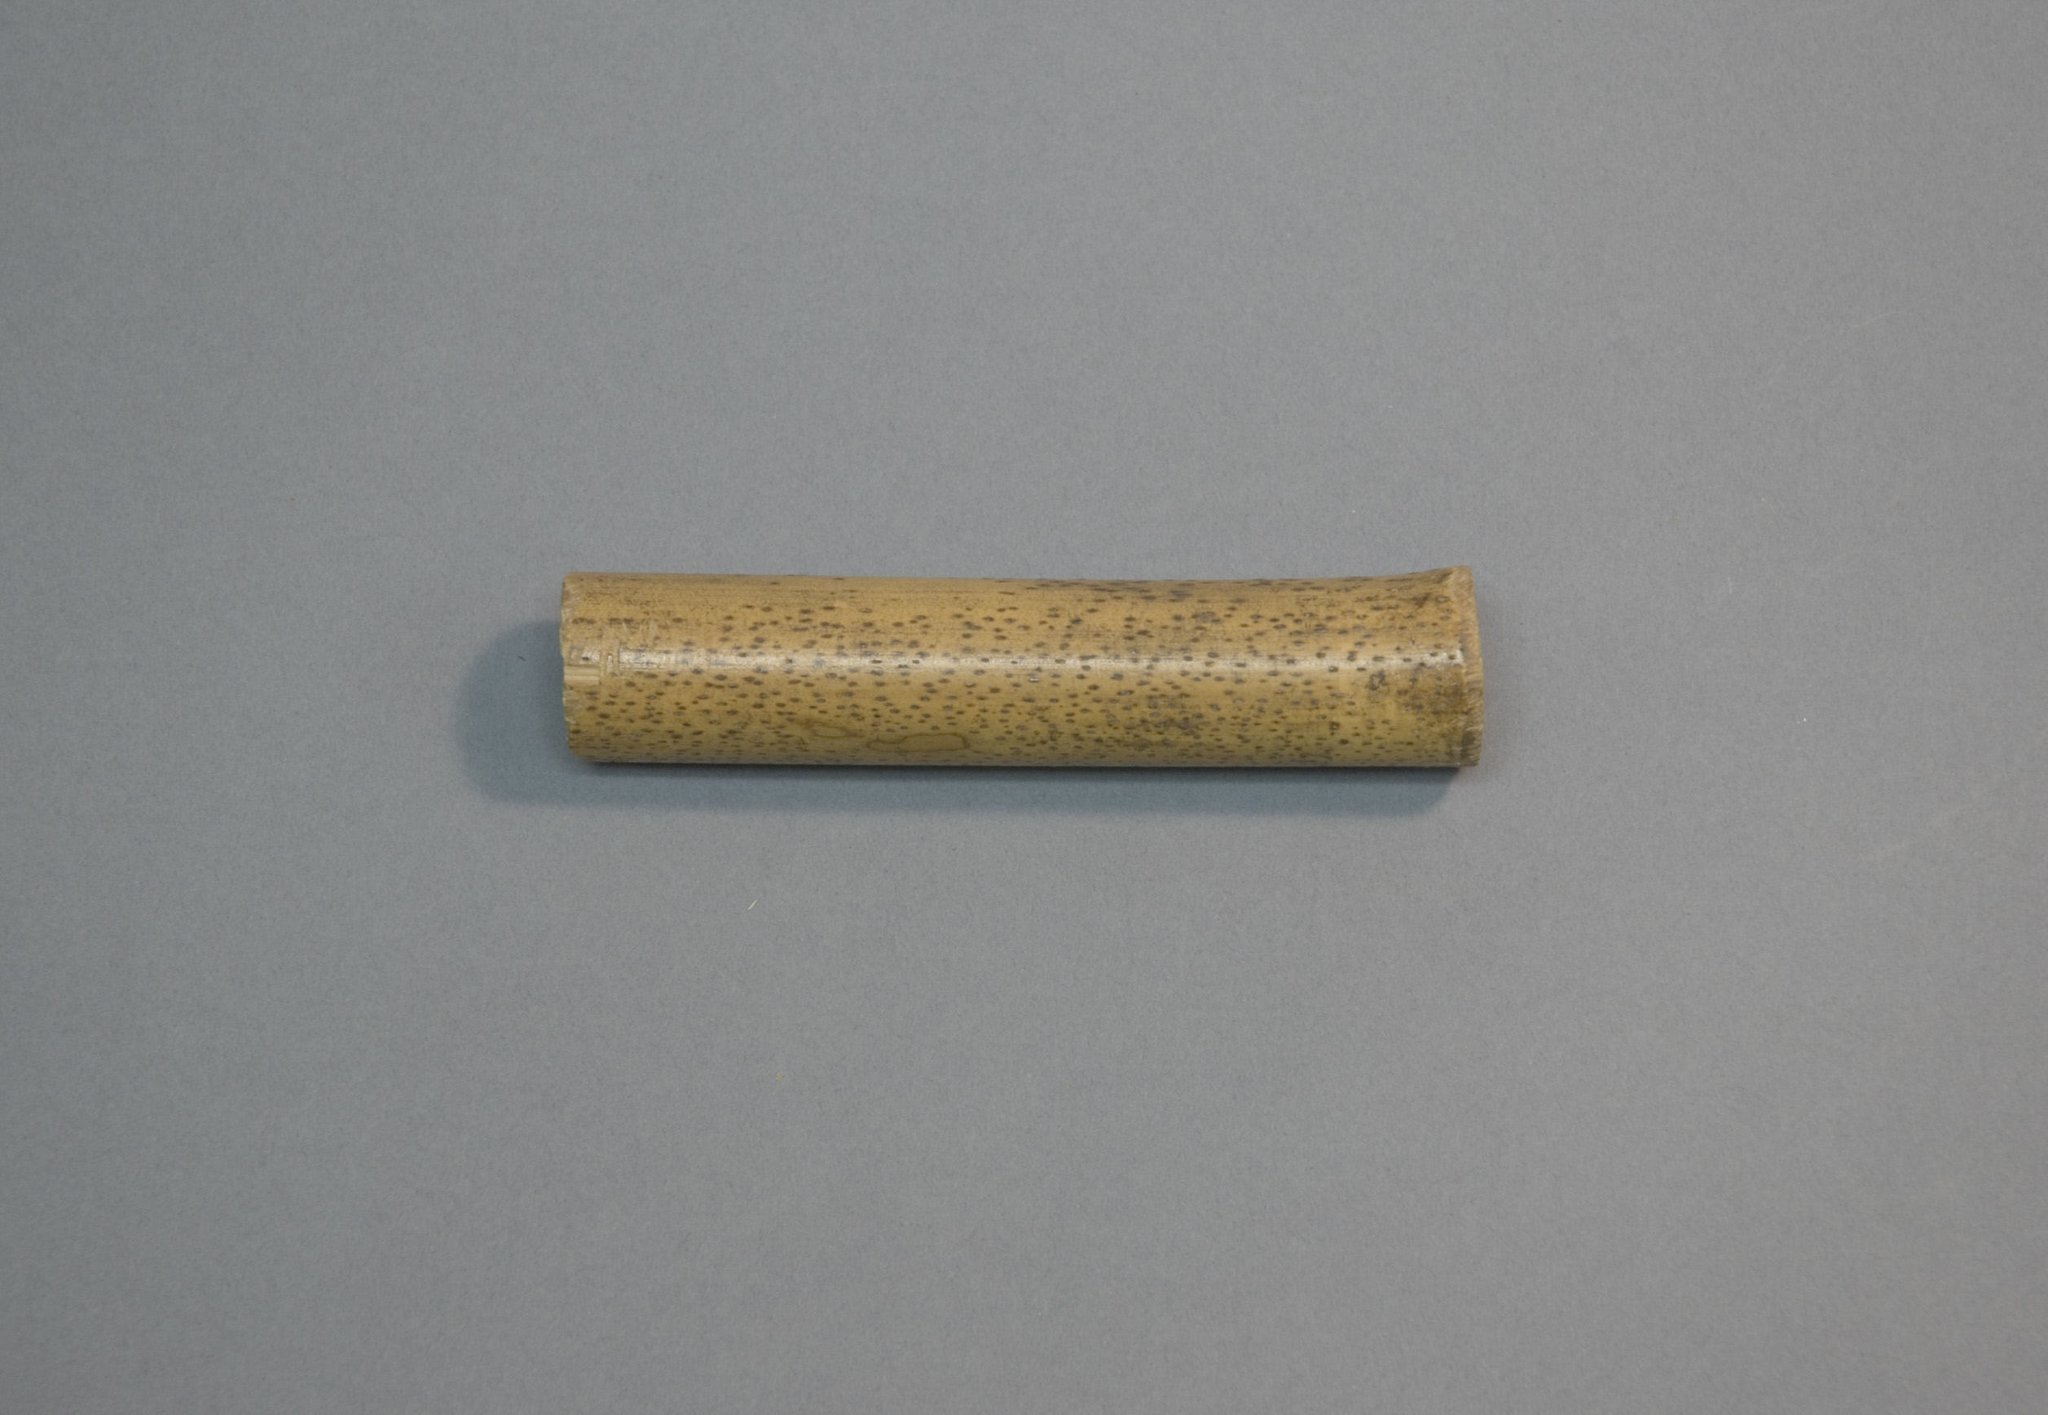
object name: jade carving tool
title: Tubular Drill for Jade Carving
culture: chinese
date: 1901-2000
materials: bamboo